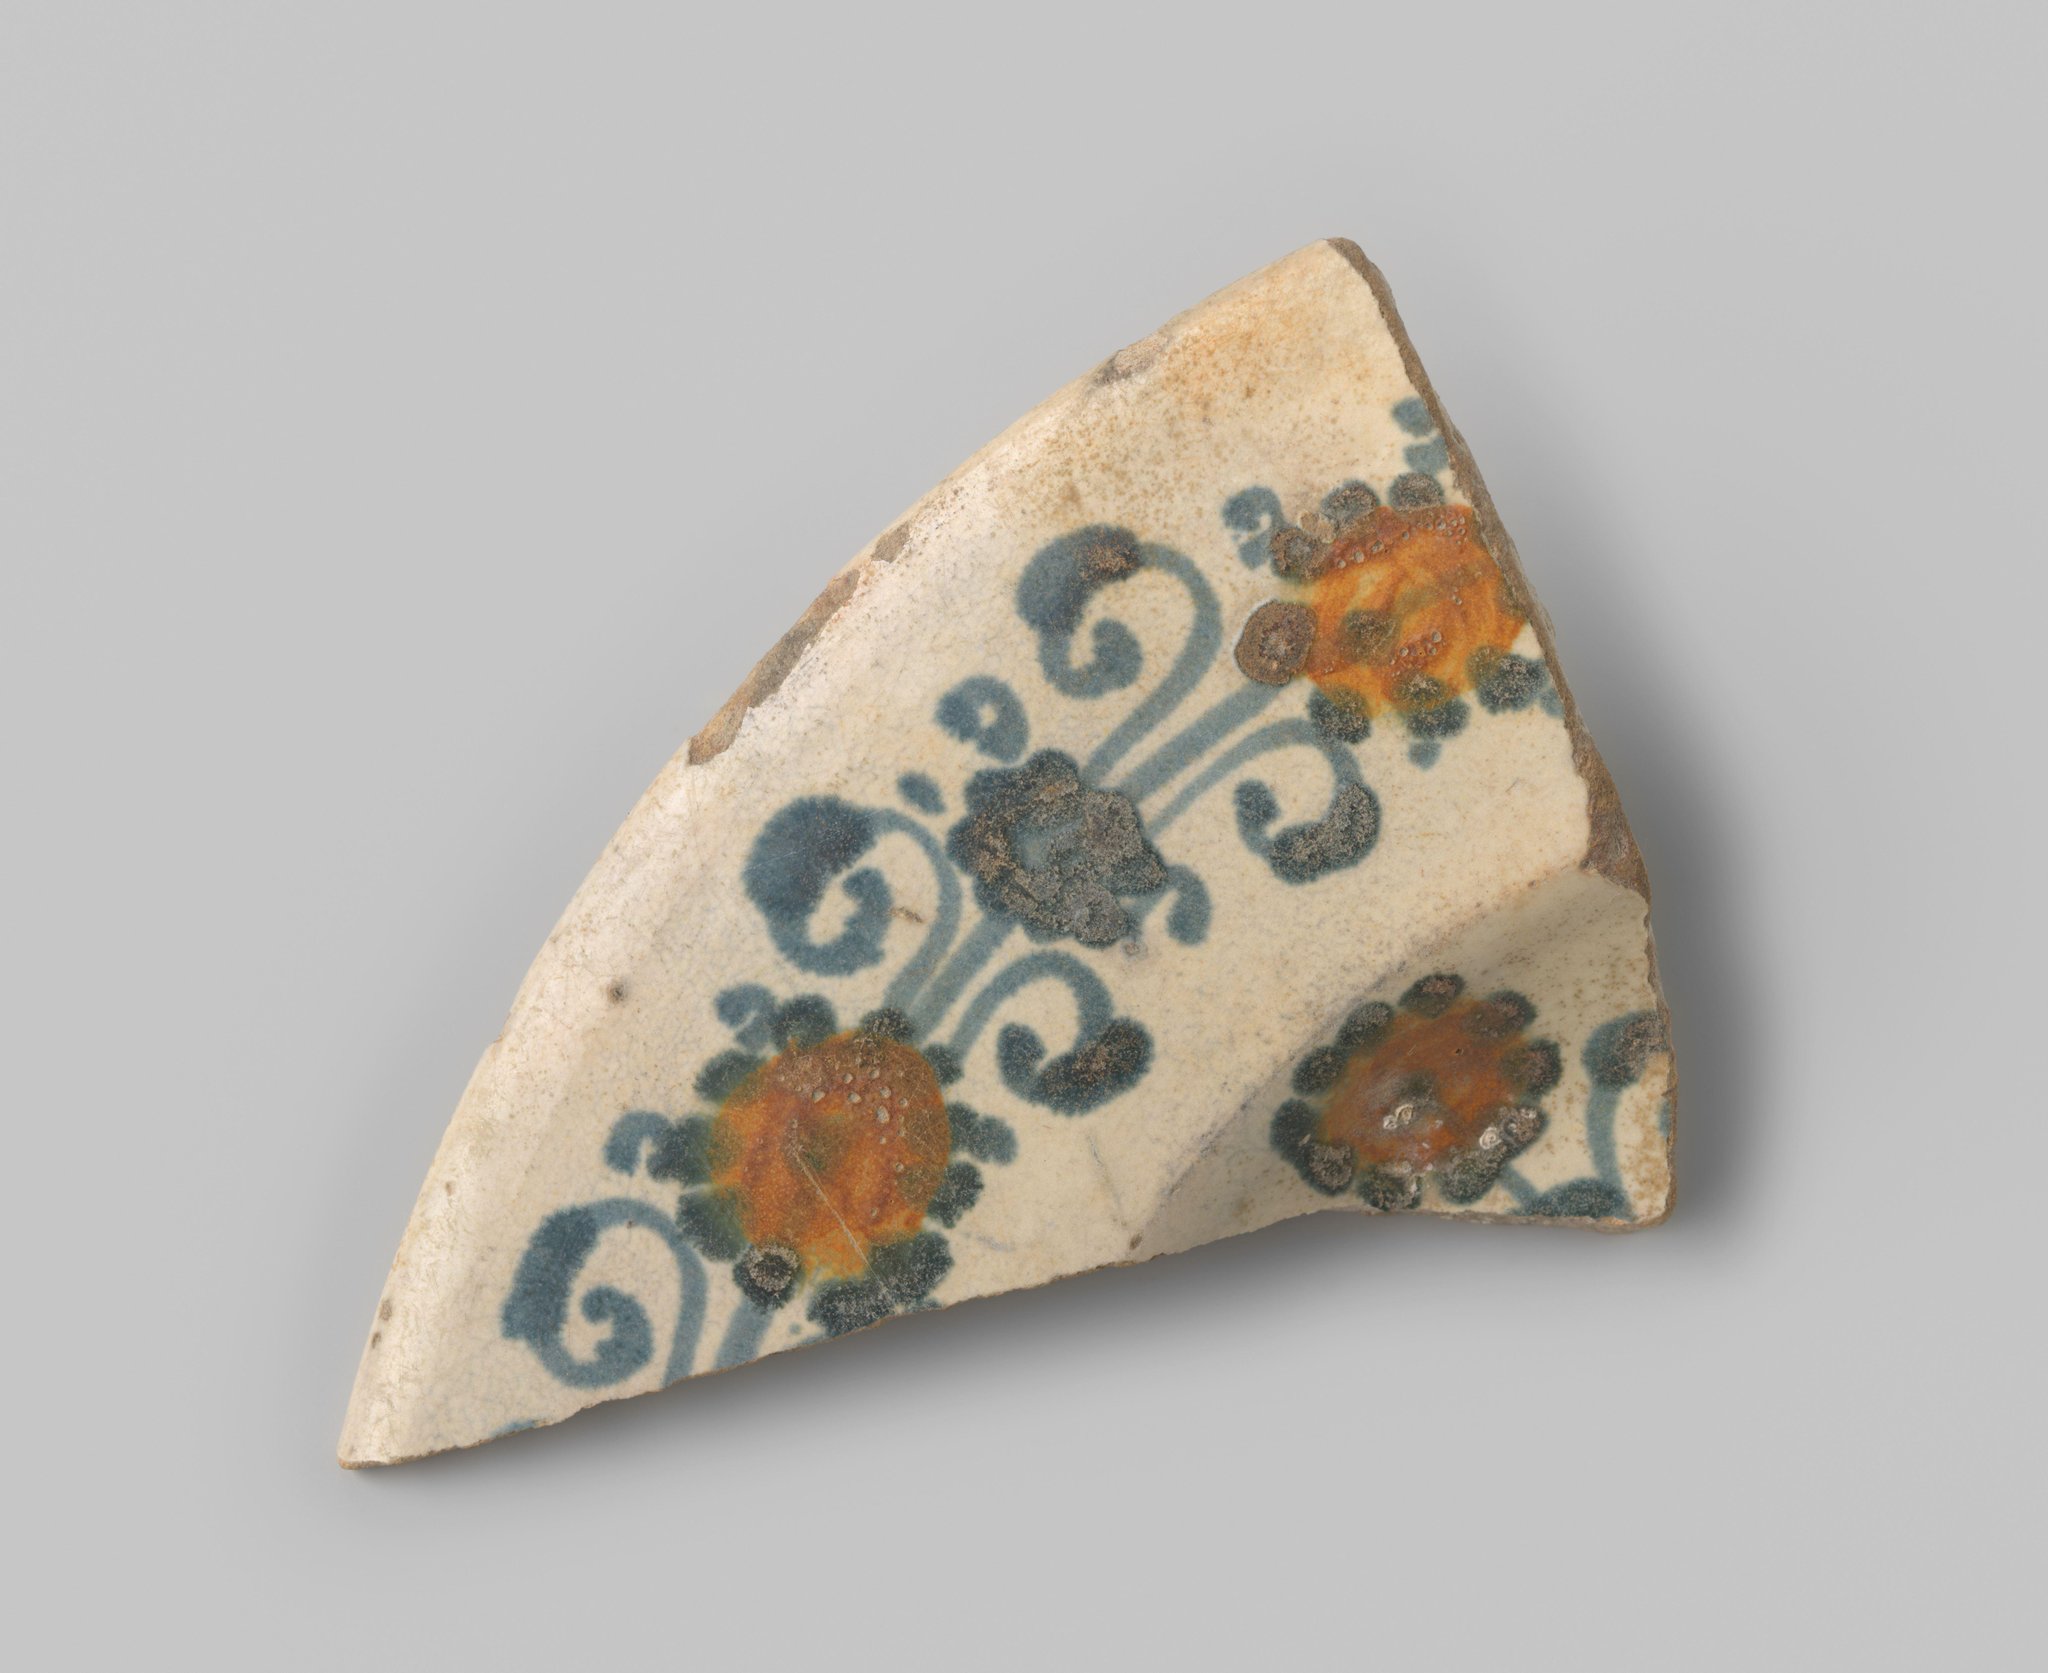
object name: sherd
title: Schotelscherf van witbakkend aardewerk, aan de voorzijde voorzien van een bloemdecoratie in blauw en geel op wit glazuur, aan de achterzijde van wit glazuur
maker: Anonymous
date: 1200-1899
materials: earthenware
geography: italy